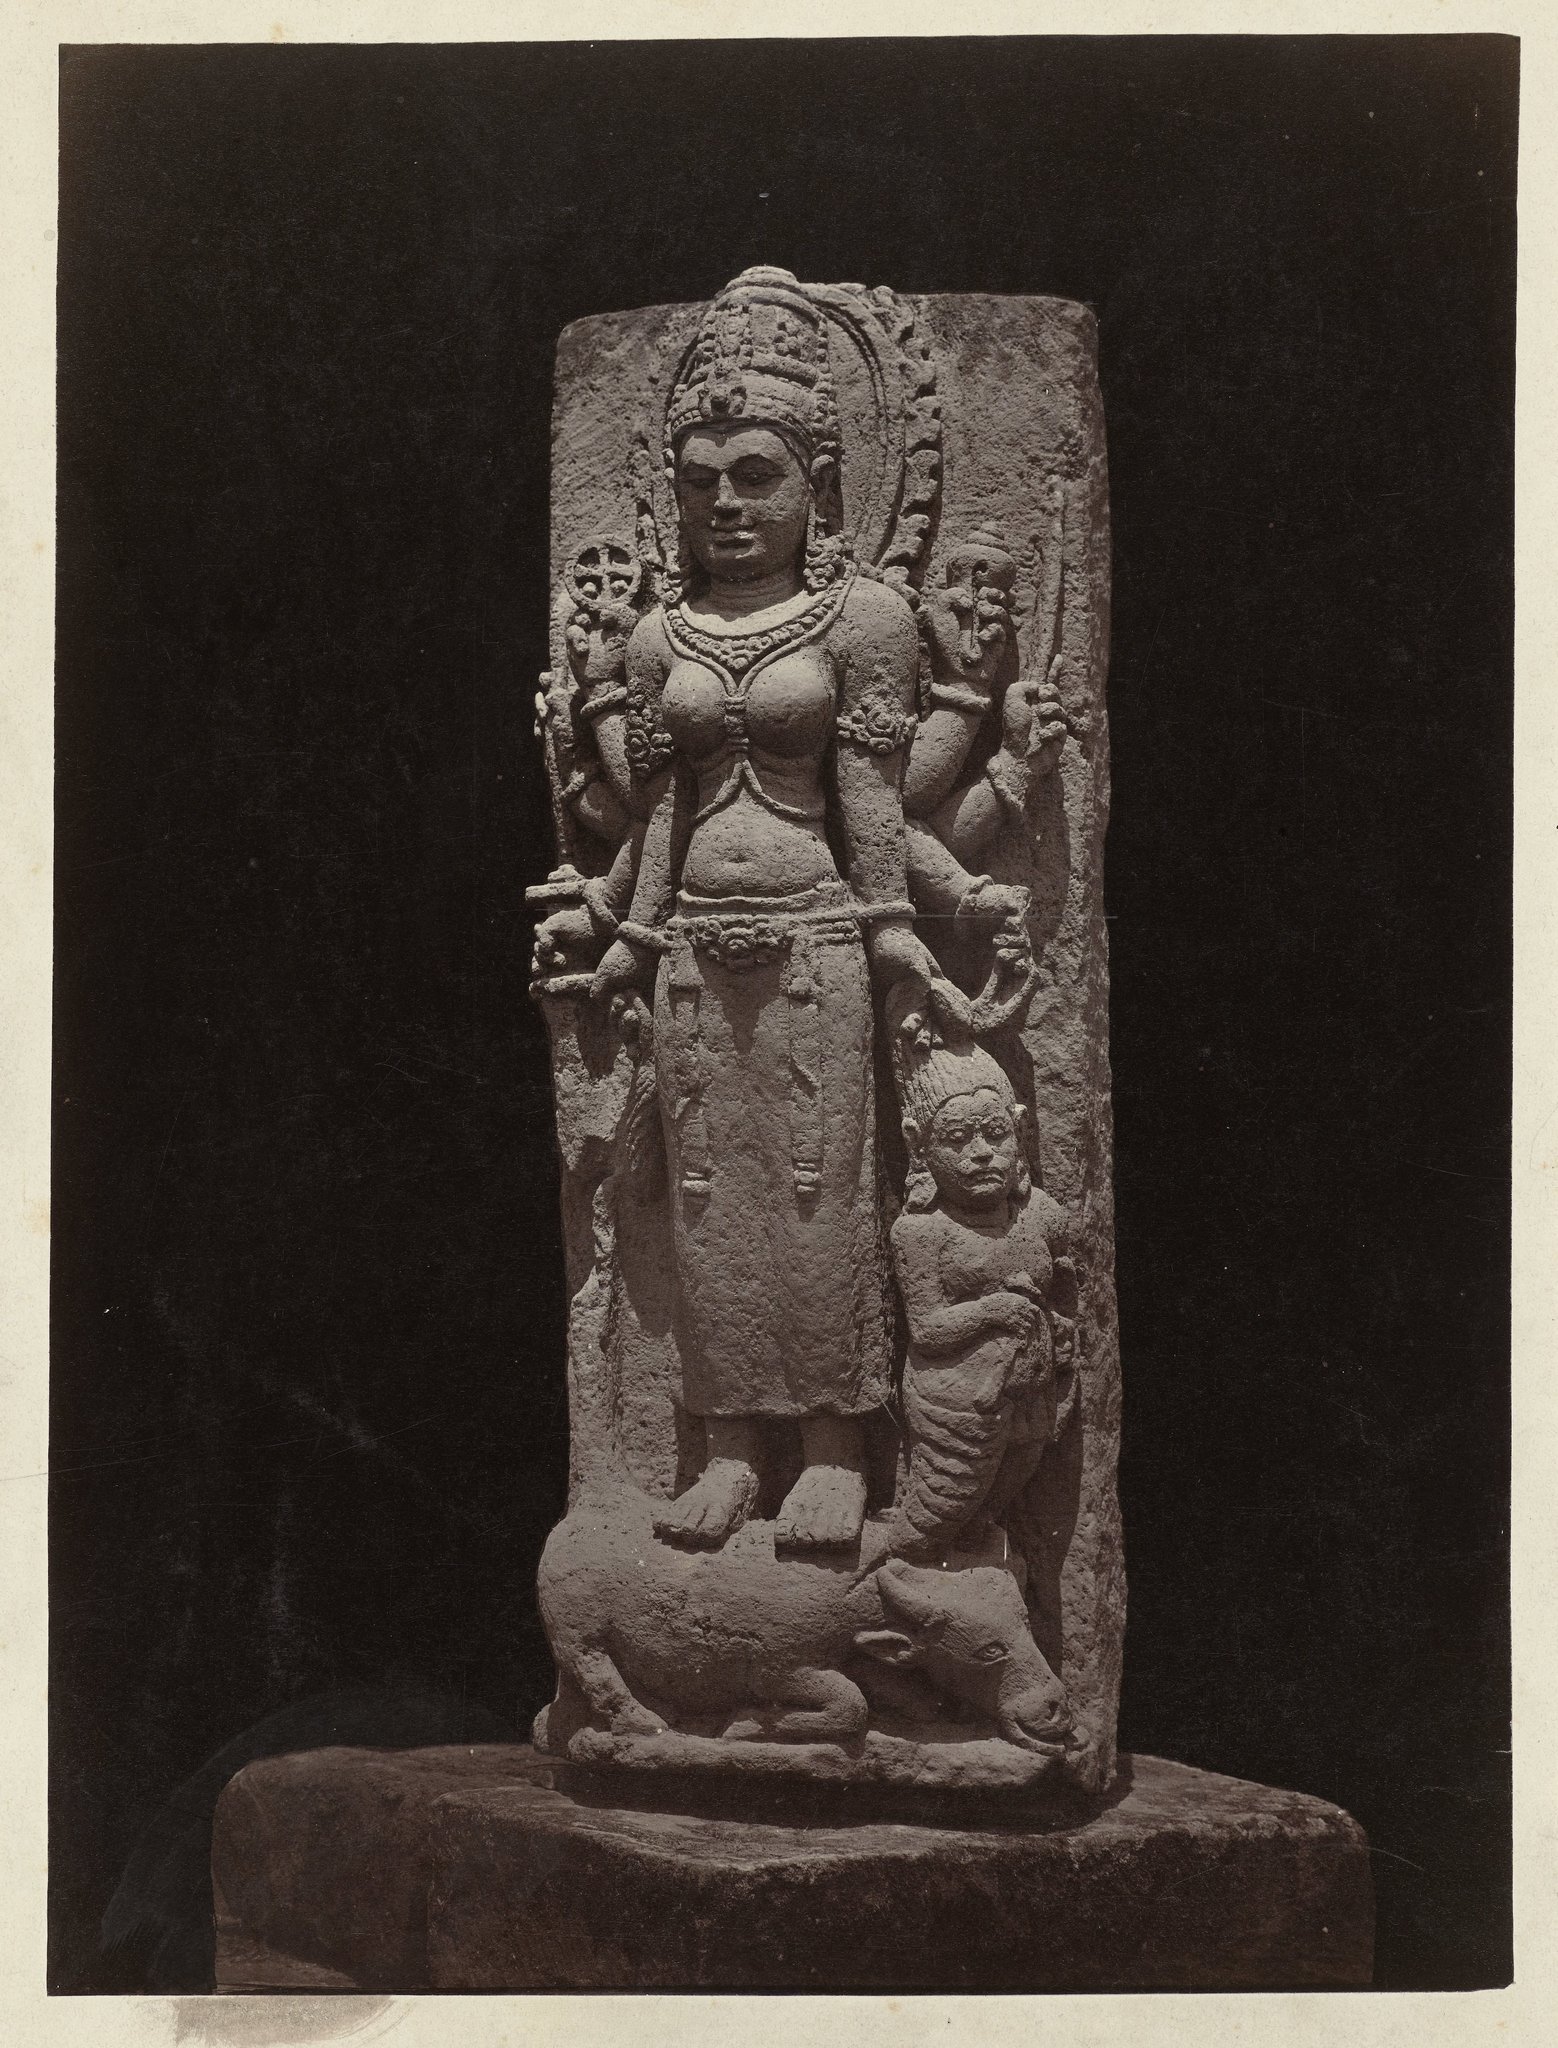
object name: photograph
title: Eight armed Durga slaying the demon Mahisha. Dieng Plateau, Wonosobo district, Central Java province 9th- 10th century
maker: isidore kinsbergen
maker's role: fotograaf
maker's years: 1821-1905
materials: cardboard, paper, photographic support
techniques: albumen print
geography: java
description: De godin Durga staat op de verslagen demonen leider Mahisha die de vorm van een buffel aan heeft genomen